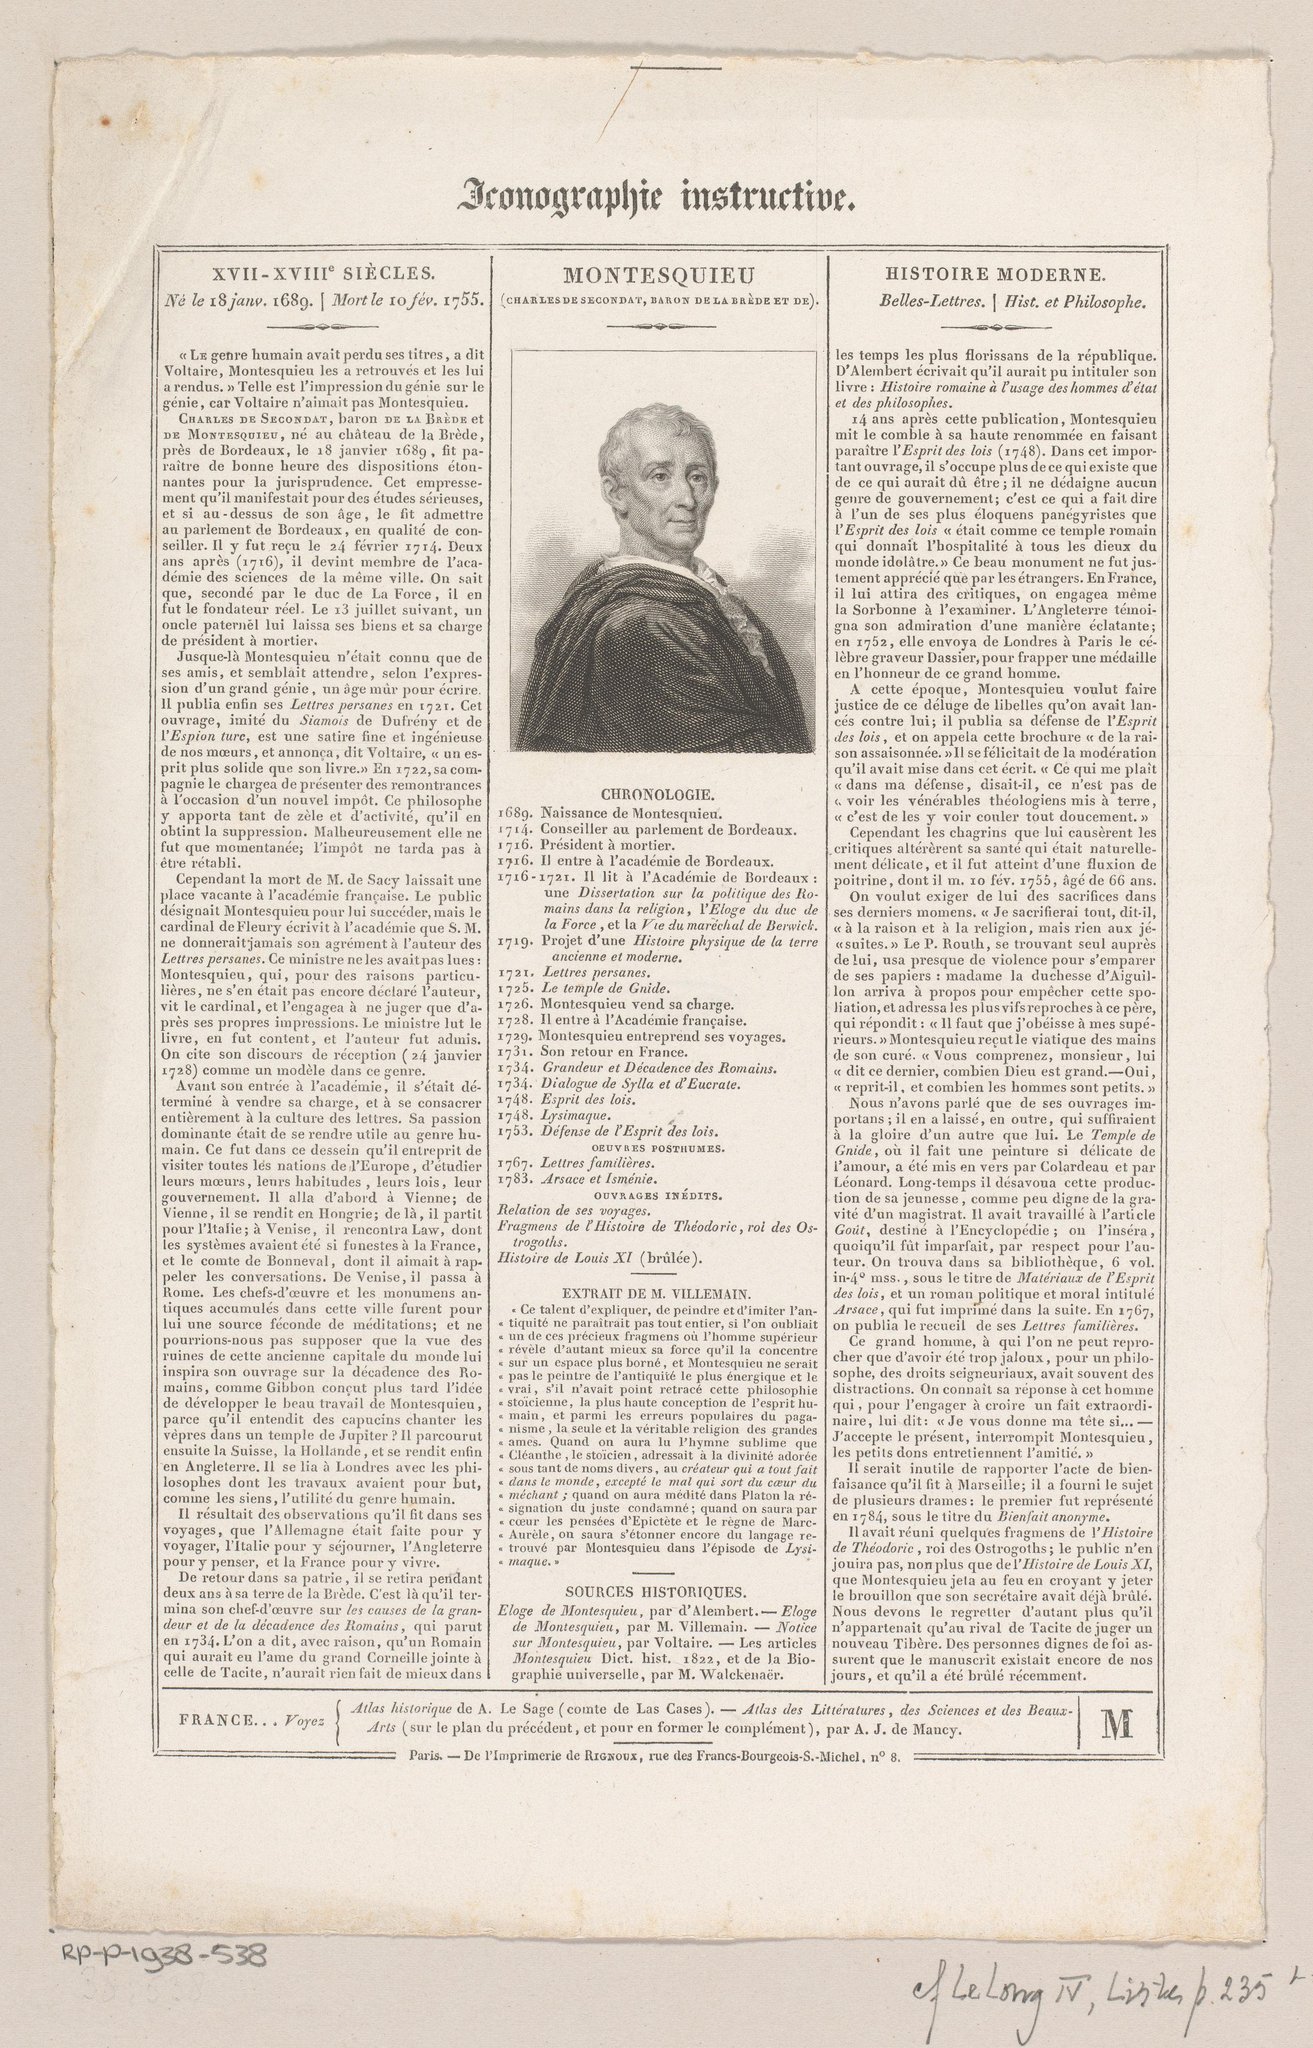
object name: print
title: Portret van Charles de Montesquieu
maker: Anonymous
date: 1839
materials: paper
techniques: letterpress printing, engraving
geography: paris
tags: paris, scholar, philosopher, historical persons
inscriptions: collector's mark: Lugt 2228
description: Prent uit: Bénard. Galerie Historique. (...) Parijs: Imprimerie de Bruneau, 1839.